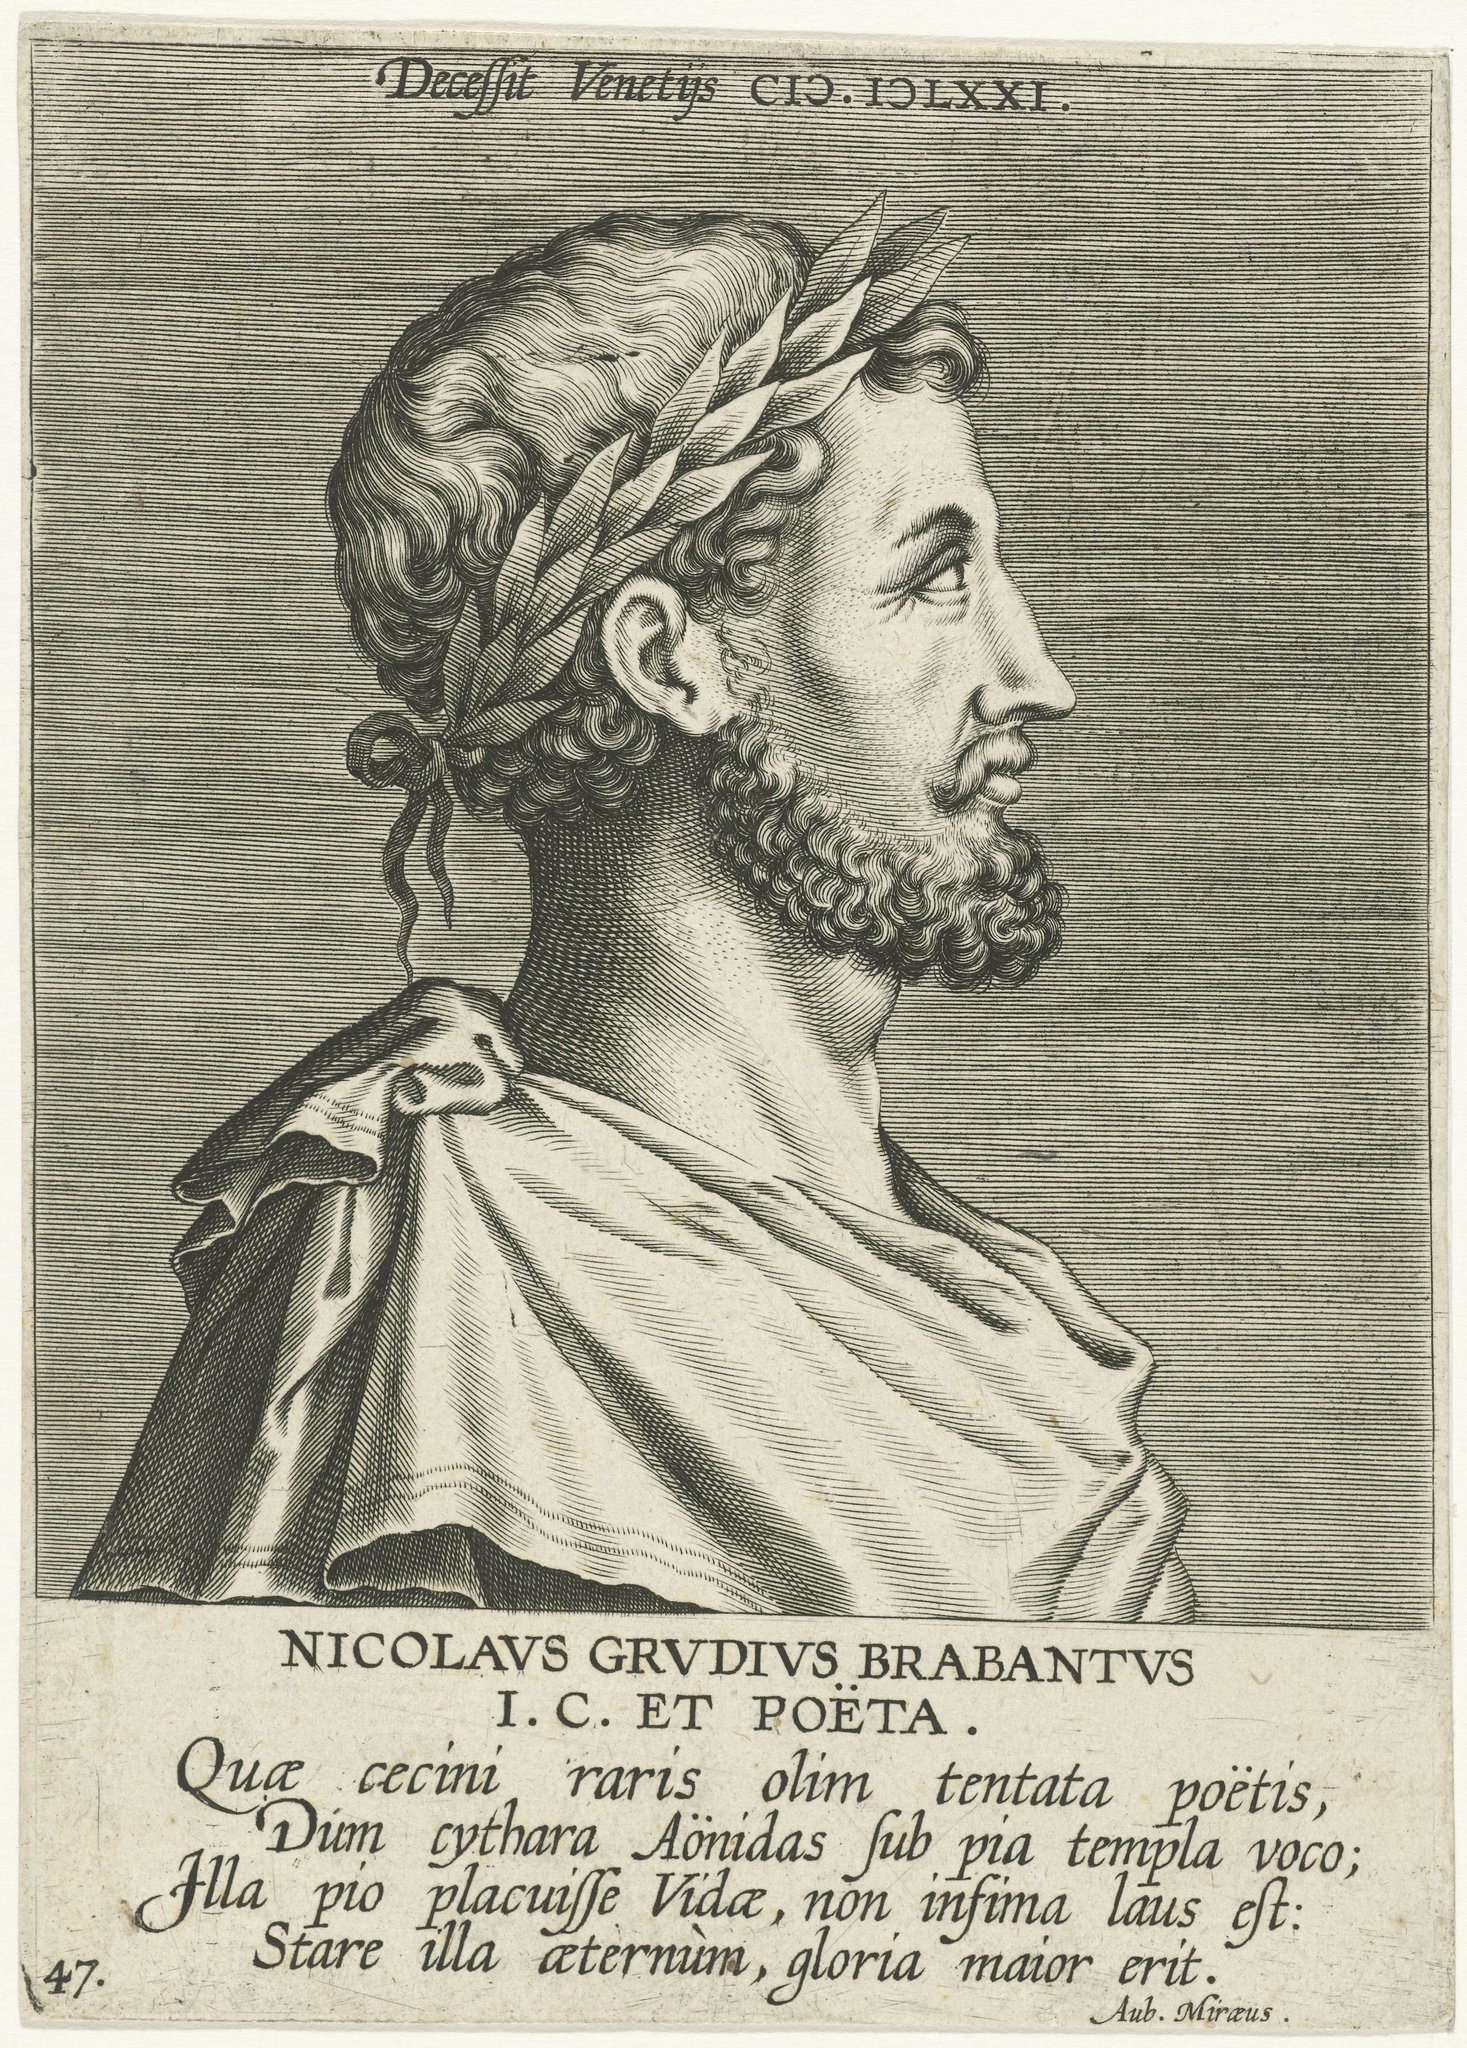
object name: print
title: Nicolavs Grvdivs Brabantvs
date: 1604-1608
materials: paper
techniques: engraving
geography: antwerp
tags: venice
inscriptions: collector's mark: Lugt 2228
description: Portret van Nicolaas Grudius, Leuvense humanist en dichter. In profiel naar rechts. De prent heeft een Latijns boven- en onderschrift en maakt deel uit van een serie van beroemde Nederlandse en Vlaamse geleerden.